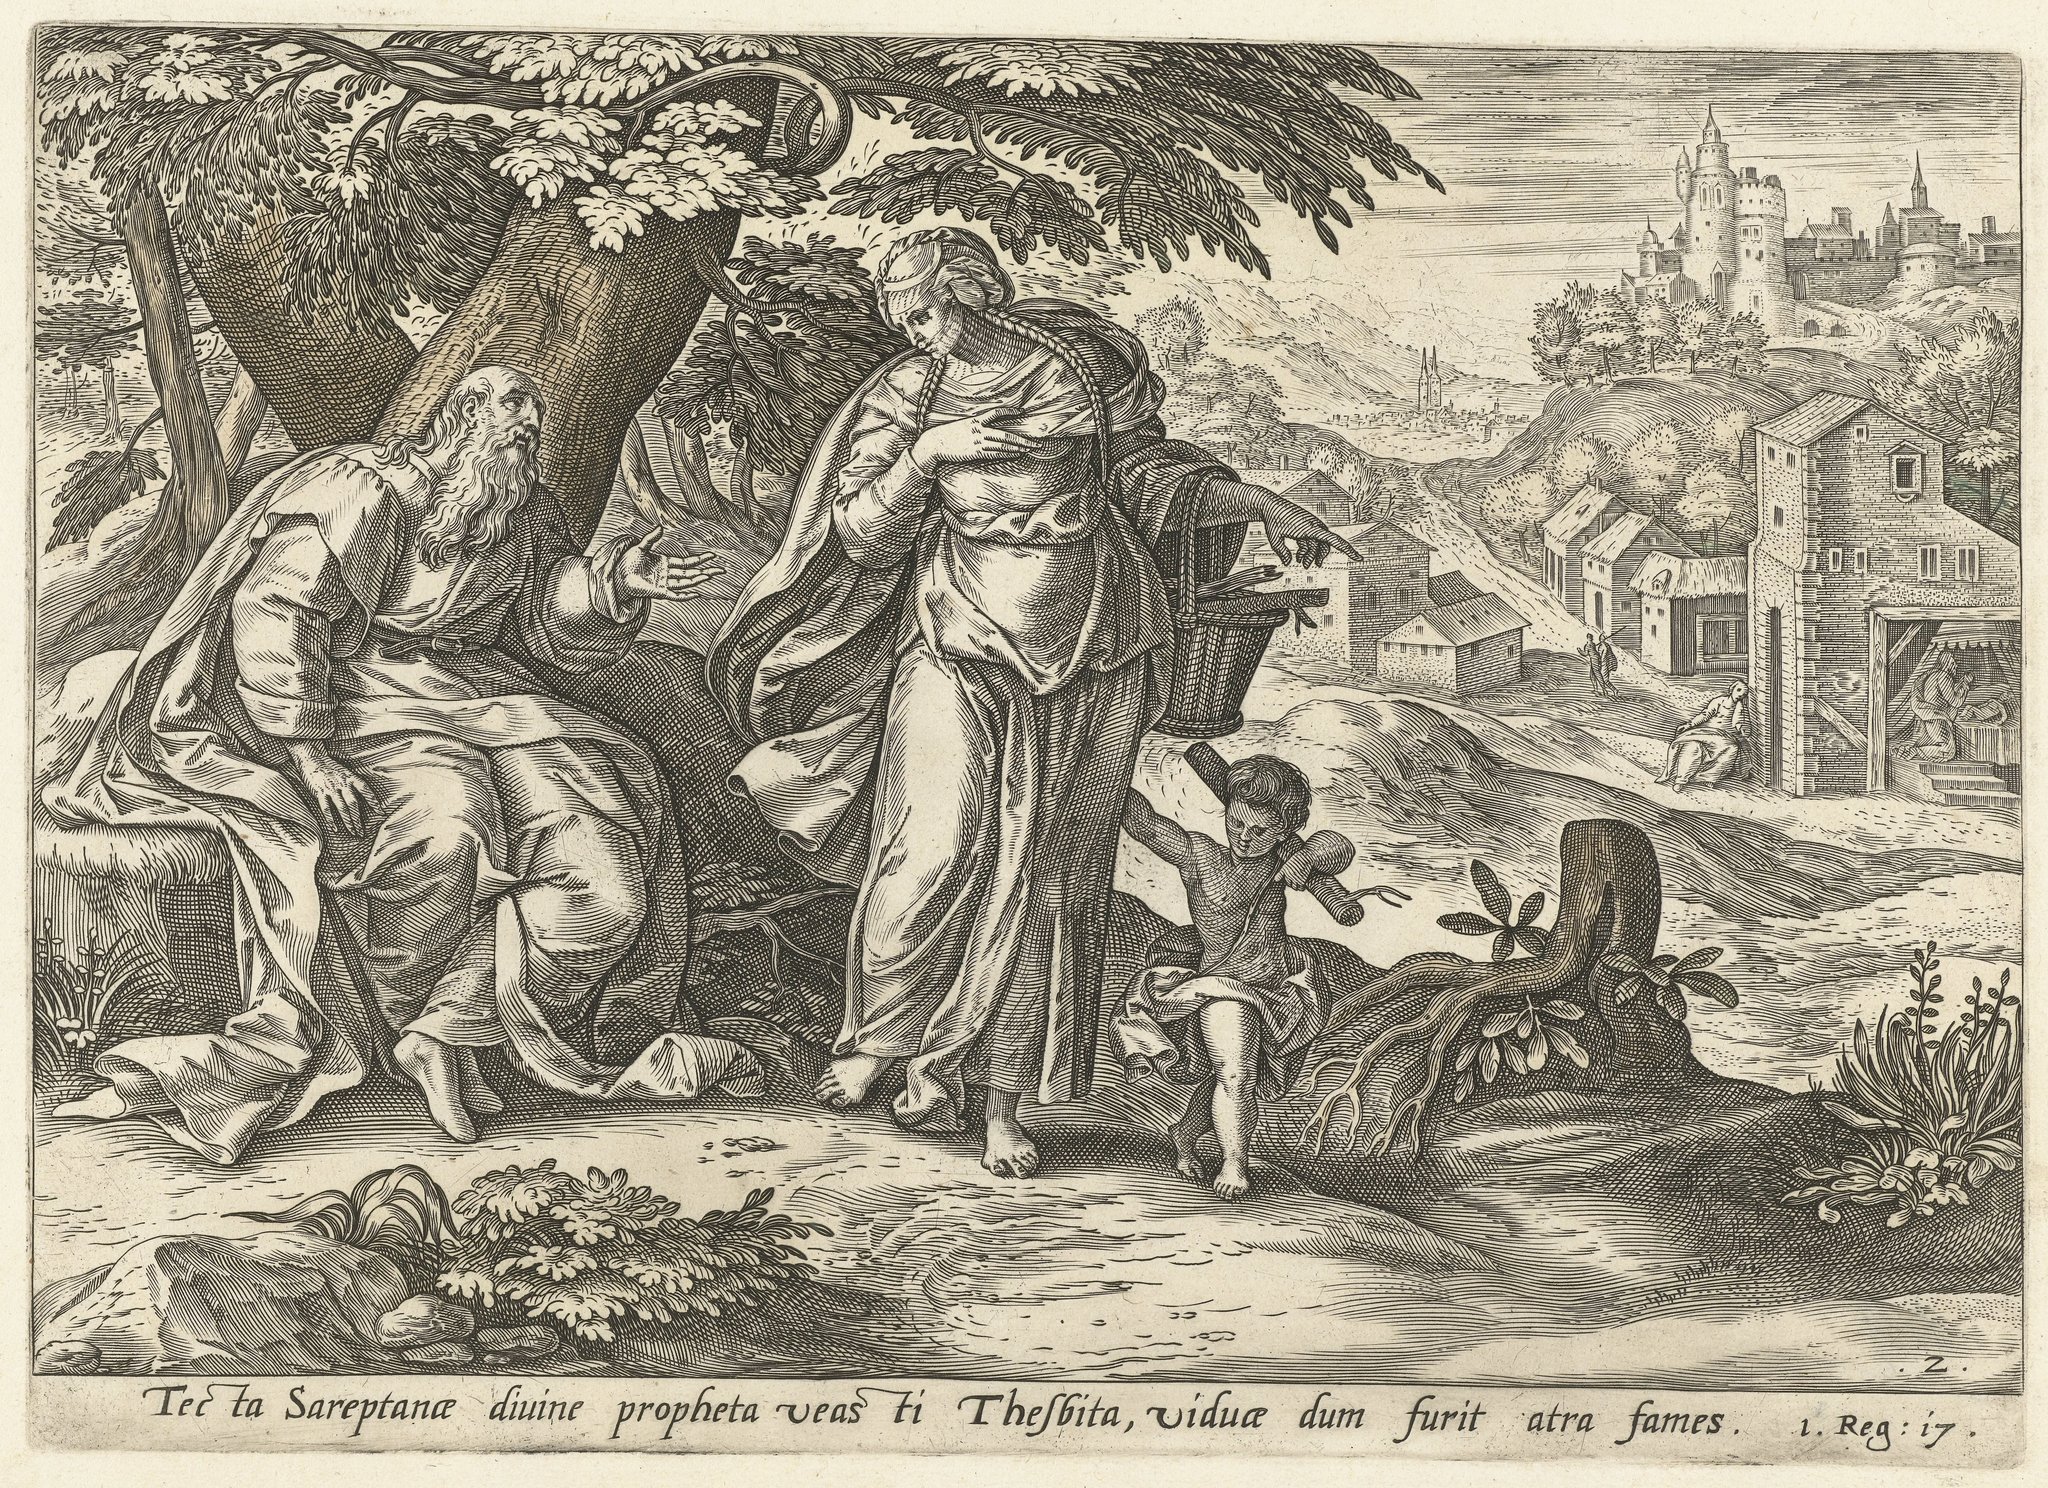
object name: print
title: Geschiedenis van Elia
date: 1579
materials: paper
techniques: engraving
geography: antwerp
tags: elijah and the widow of zarephath (1 kings 17:7-24)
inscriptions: collector's mark: Lugt 2228a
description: De profeet Elia spreekt een vrouw met een kindje aan even buiten een dorp; hij vraagt haar om eten voor hem te maken. Op de achtergrond rechts is te zien hoe Elia het zoontje van de vrouw, nadat het bezweken is aan een ziekte, tot leven wekt. Onder de voorstelling een regel tekst in Latijn. Deze prent is onderdeel van een serie van vier prenten die het verhaal van de profeet Elia verbeelden.